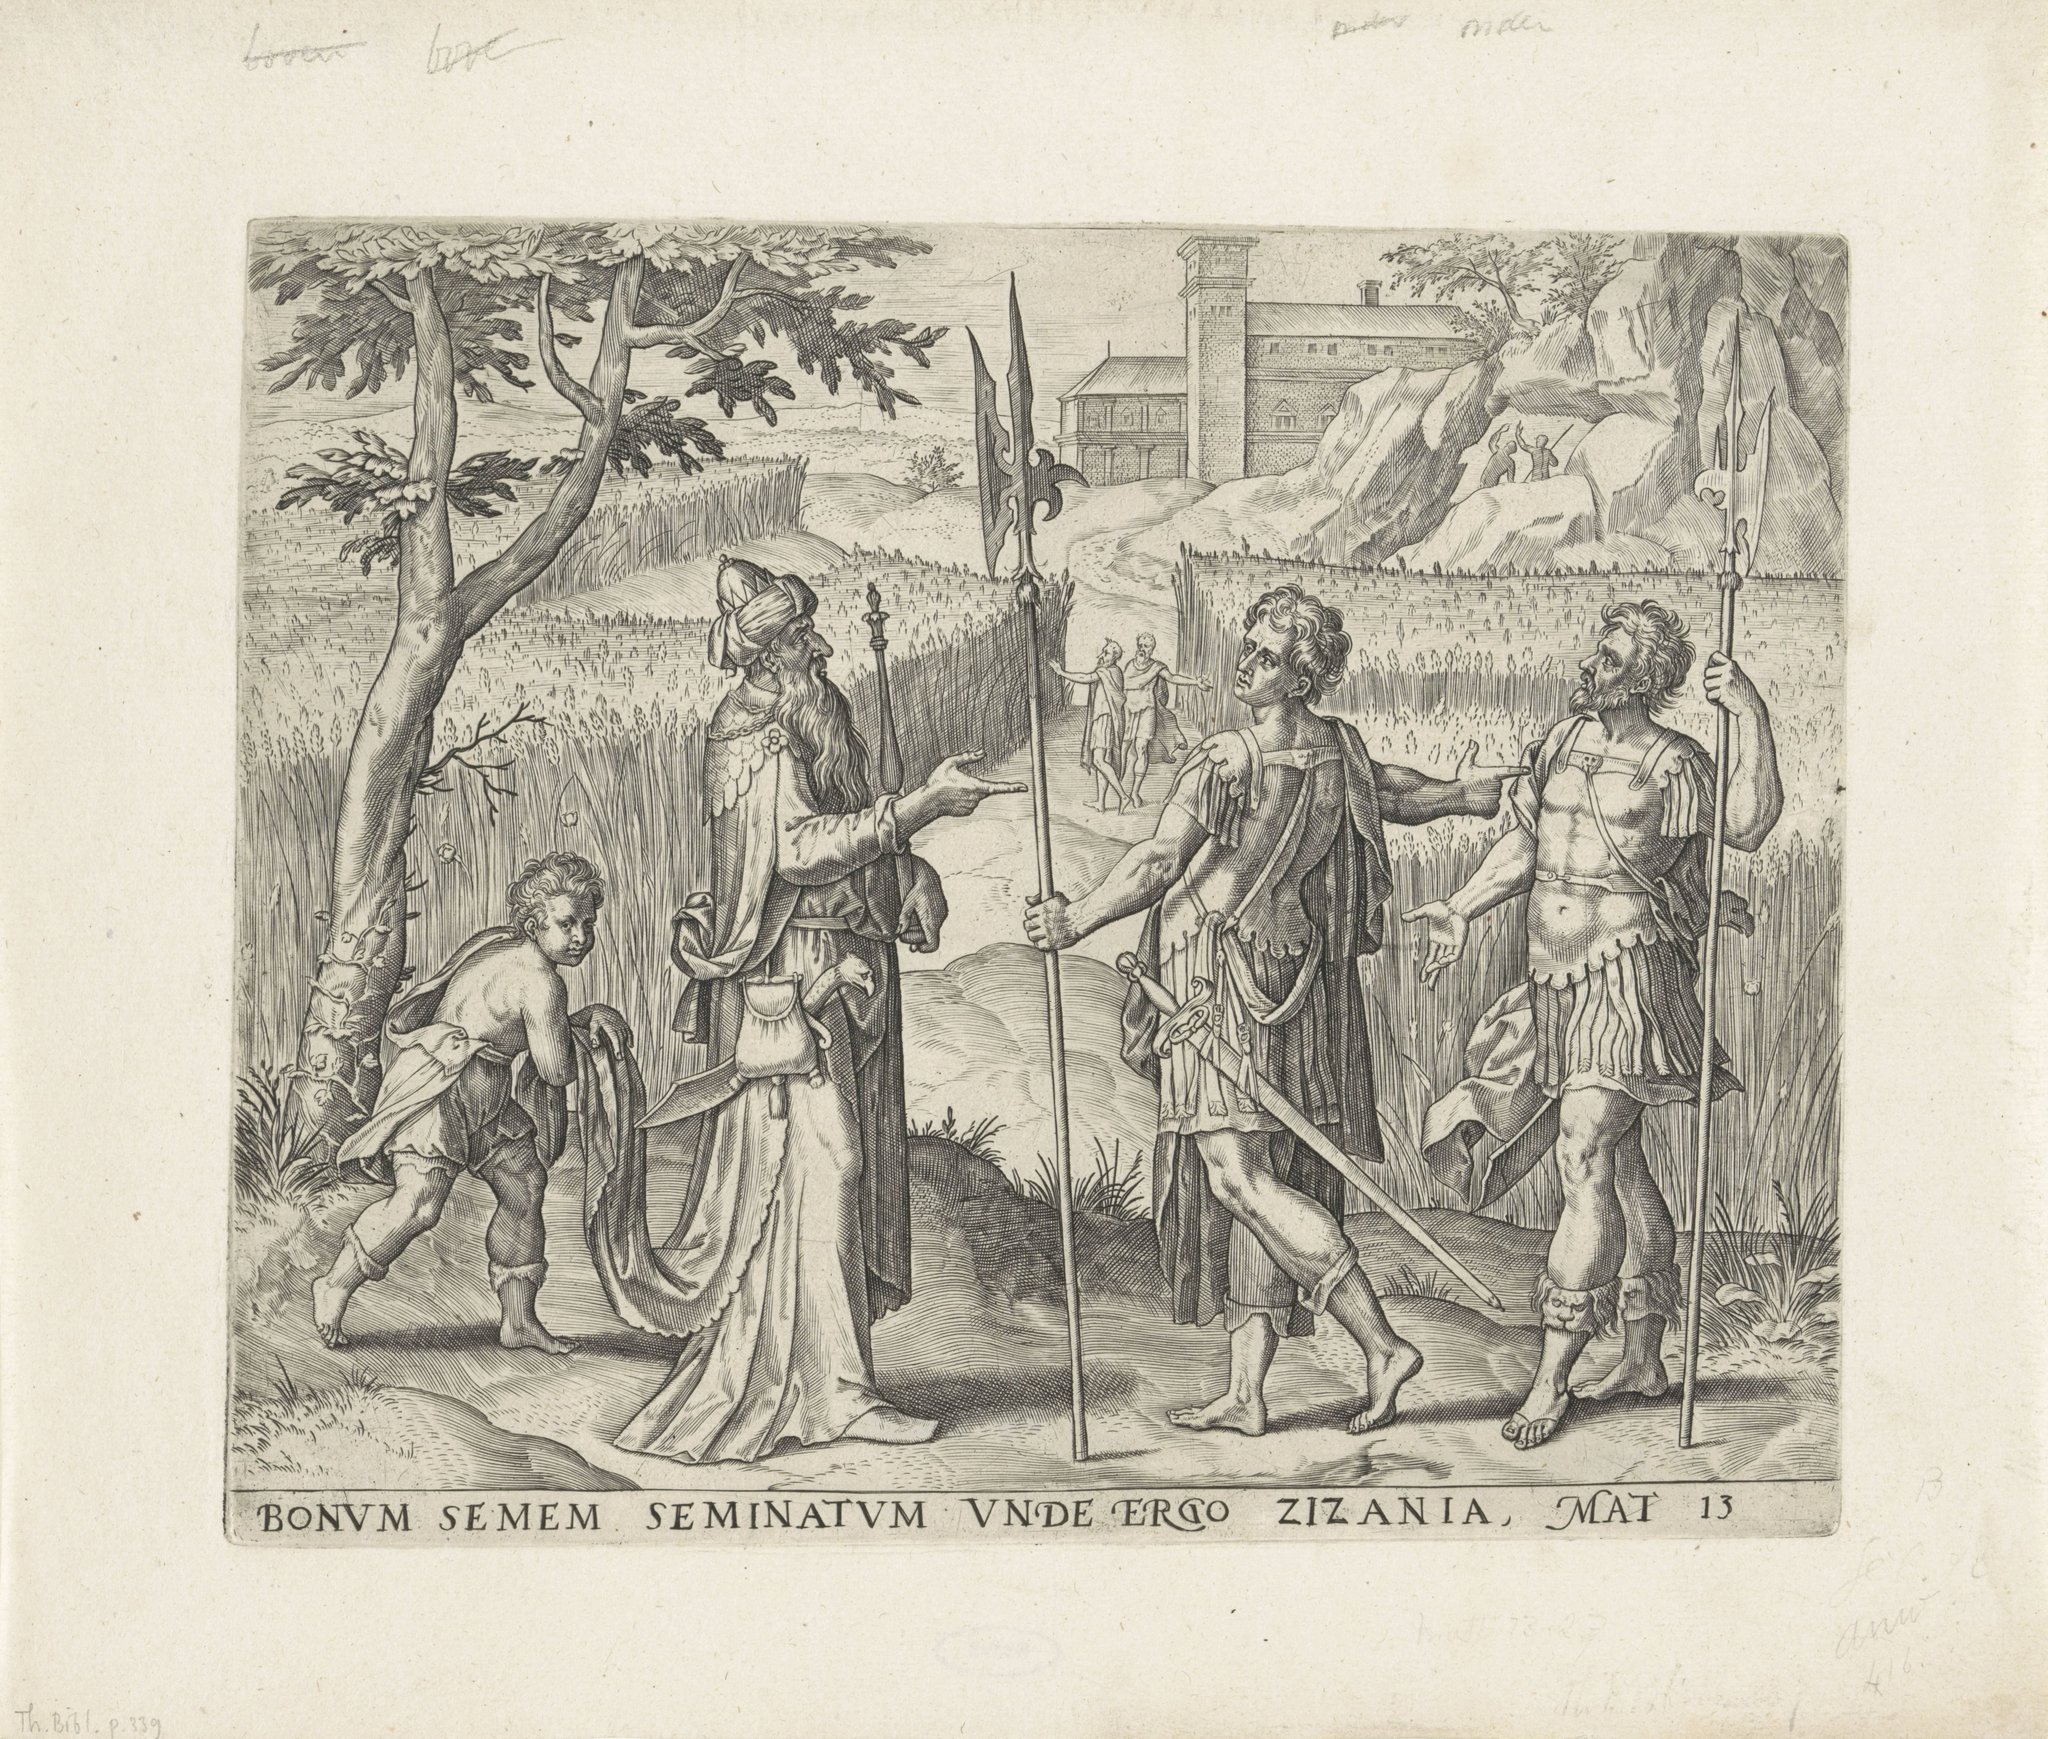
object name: print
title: Thesaurus sacrarum historiarum veteris testamenti (...)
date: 1579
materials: paper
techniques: engraving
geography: antwerp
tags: a sower sowed good seeds in his field ~ tares among the wheat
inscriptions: collector's mark: Lugt 2228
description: De knechten, beiden met een hellebaard in de hand, vragen aan de landheer of zij het onkruid tussen het graan moeten wieden. De landheer geeft als antwoord dat het graan en het onkruid moeten blijven groeien tot aan de oogst. Een jongen houdt het kleed van de landheer vast. Onder de voorstelling een verwijzing in het Latijn naar de Bijbeltekst in Mat. 13.